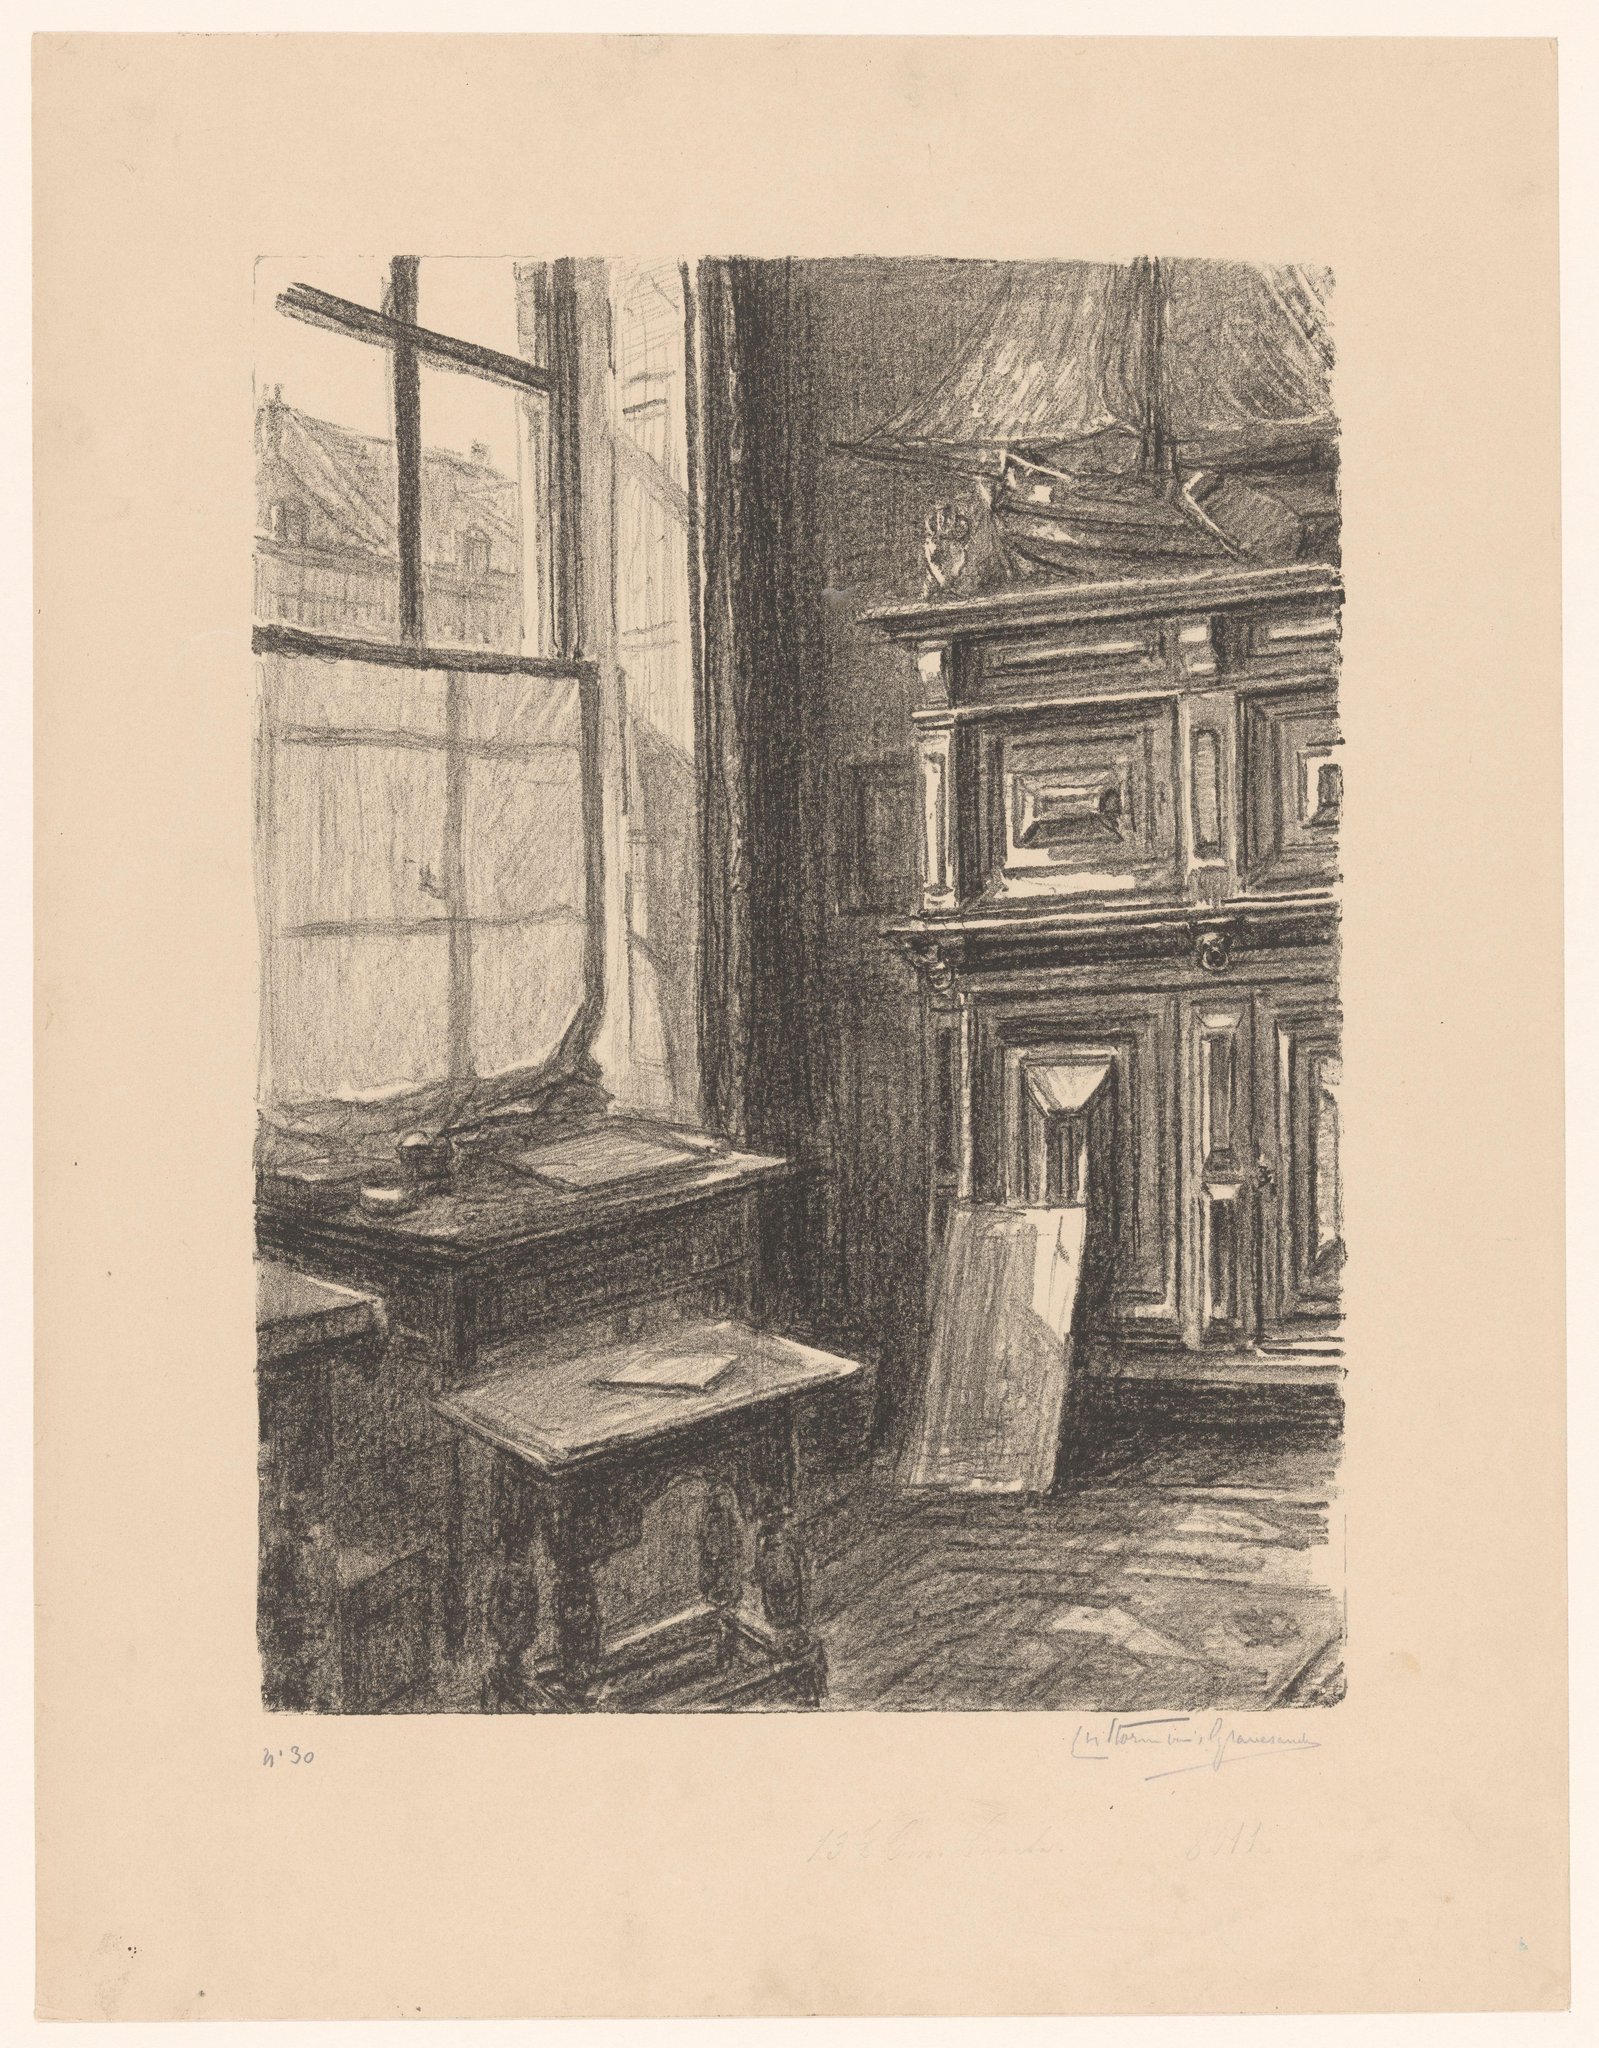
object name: print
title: Interieur van een atelier met een tafel bij het venster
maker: carel nicolaas storm van s-gravesande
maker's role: draughtsman, print maker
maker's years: 1841-1924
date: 1851-1924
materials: paper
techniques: lithograph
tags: window, workshop, studio of the artist (in general)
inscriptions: number: ‘n. 30’, collector's mark: Lugt 2228, inscription: ‘13 1/2 Cm. [...] 8011’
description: Mogelijk vermeld in: Storm van 's-Gravesande, Charles. Catalogue des eaux-fortes et lithographies. New York: s.n., 1903, of in een onbekende latere uitgave van het manuscript. Vermoedelijk vermeld als catalogusnummer 30.